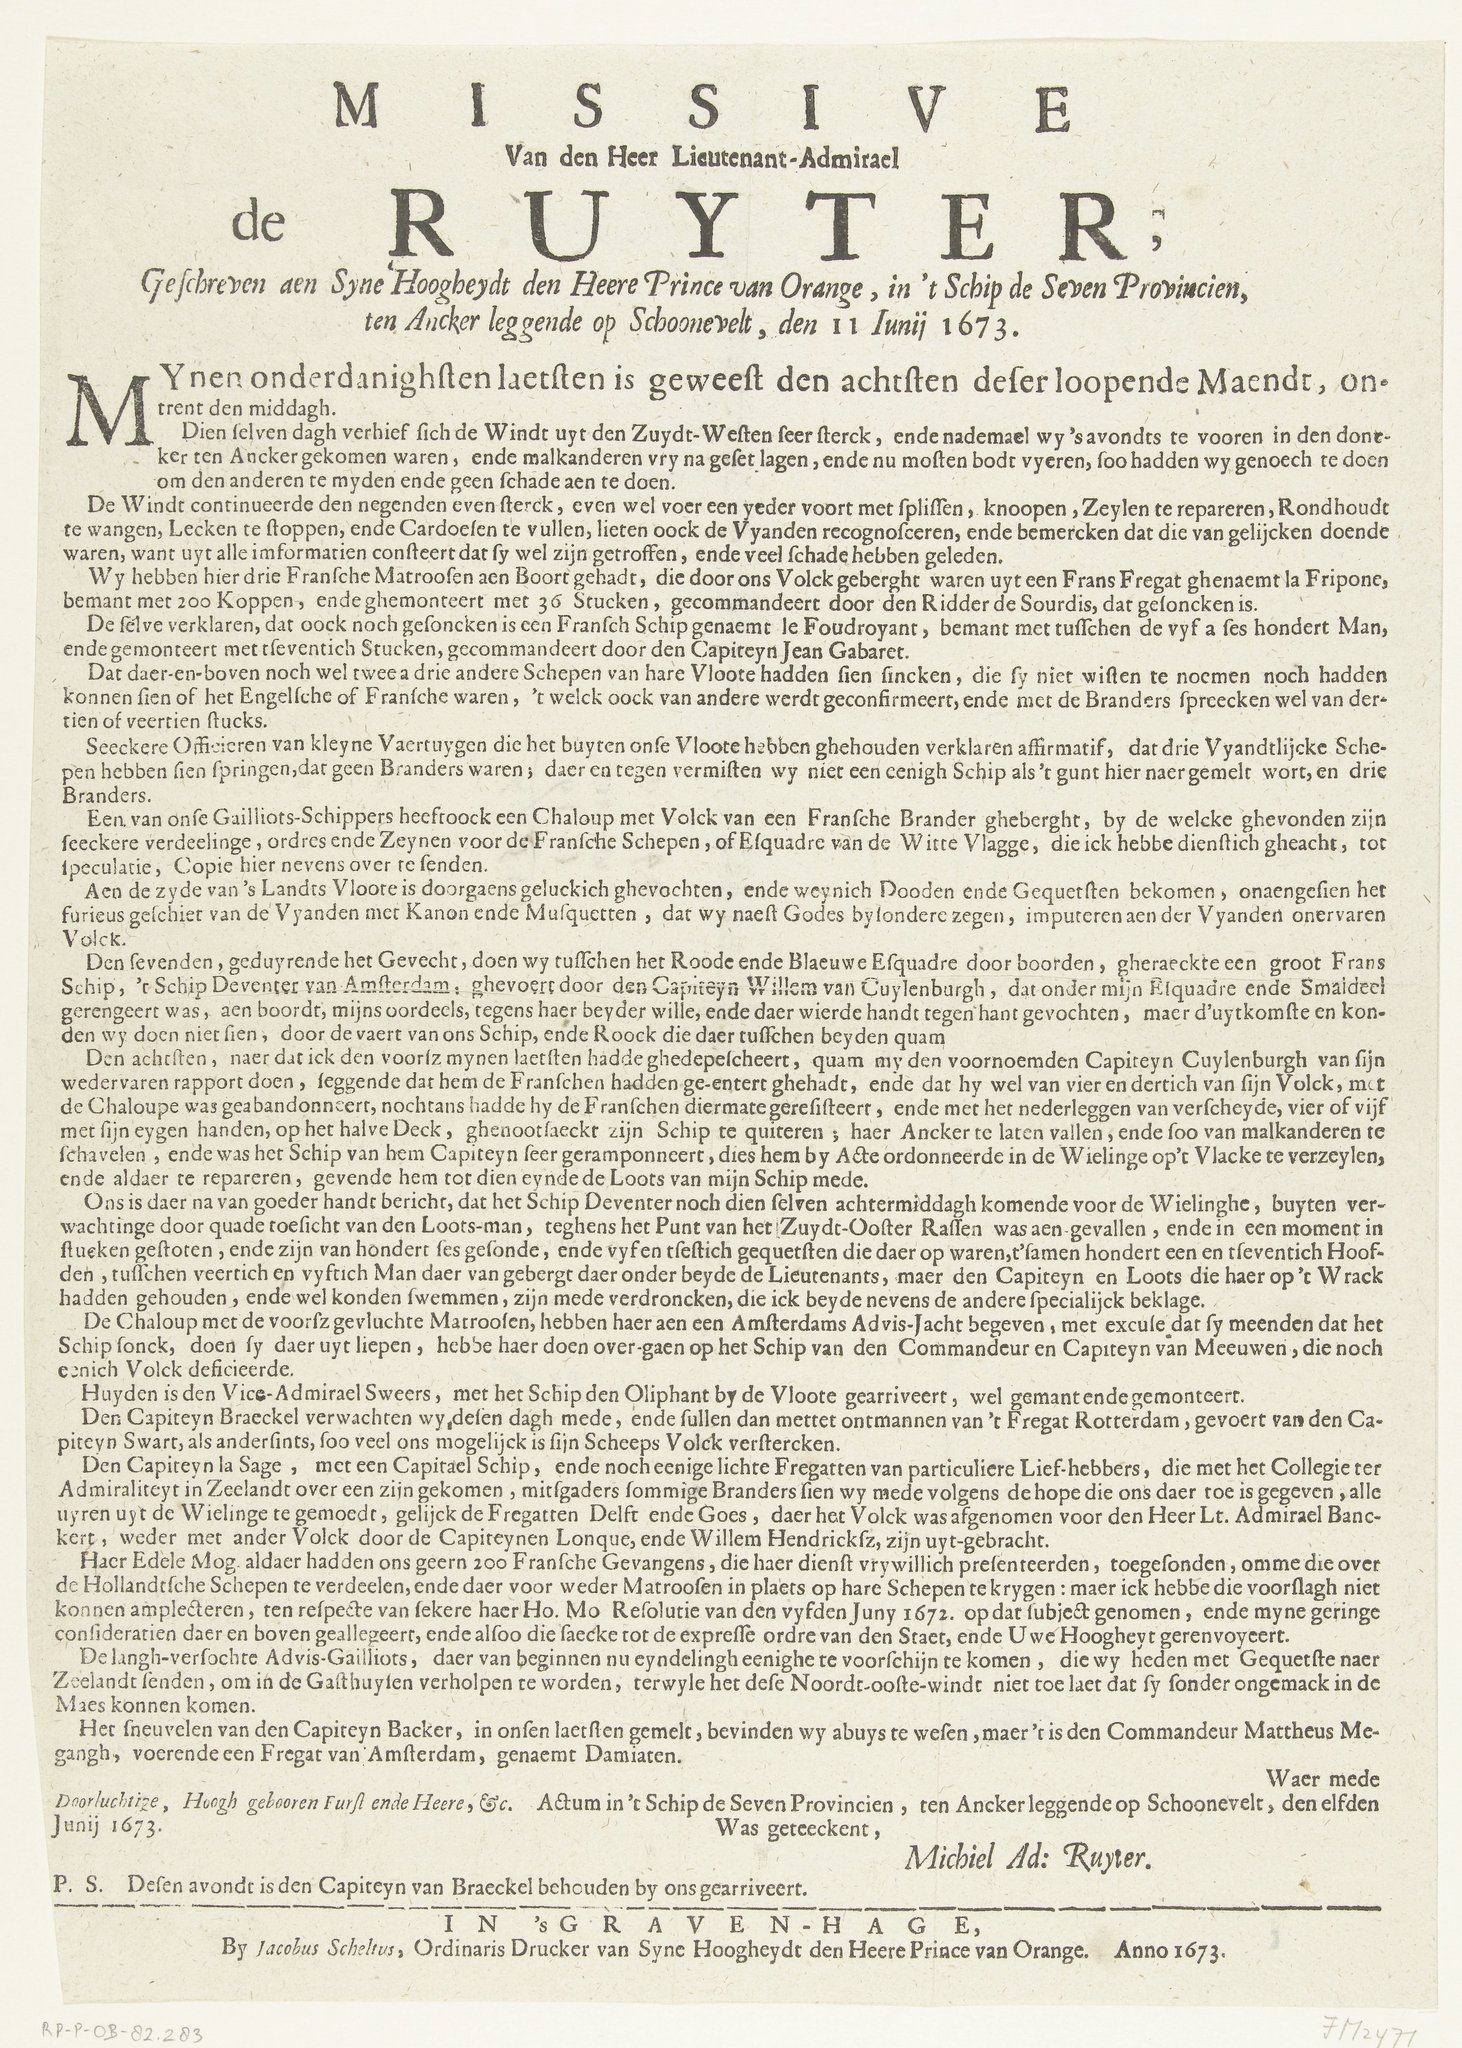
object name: text sheet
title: Missive van De Ruyter aan prins Willem III na de overwinning in de zeeslag op Schoonevelt, 11 juni 1673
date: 1673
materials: paper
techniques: letterpress printing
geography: northern netherlands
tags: prague, london, print maker, draughtsman, prinz ruprecht, flushing, michiel adriaenszoon de ruyter, rotterdam, cornelis tromp, first battle of schooneveld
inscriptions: date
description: Missive van 11 juni 1673 van admiraal Michiel Adriaenszoon de Ruyter aan prins Willem III over verschillende gebeurtenissen na de overwinning behaald in de zeeslag op Schoonevelt op 7 juni 1673 door de vloot van de Republiek onder Michiel de Ruyter en Cornelis Tromp op de gecombineerde Engels-Franse vloot onder Prins Rupert en graaf Jean d'Estrées. Tekst in twee kolommen.